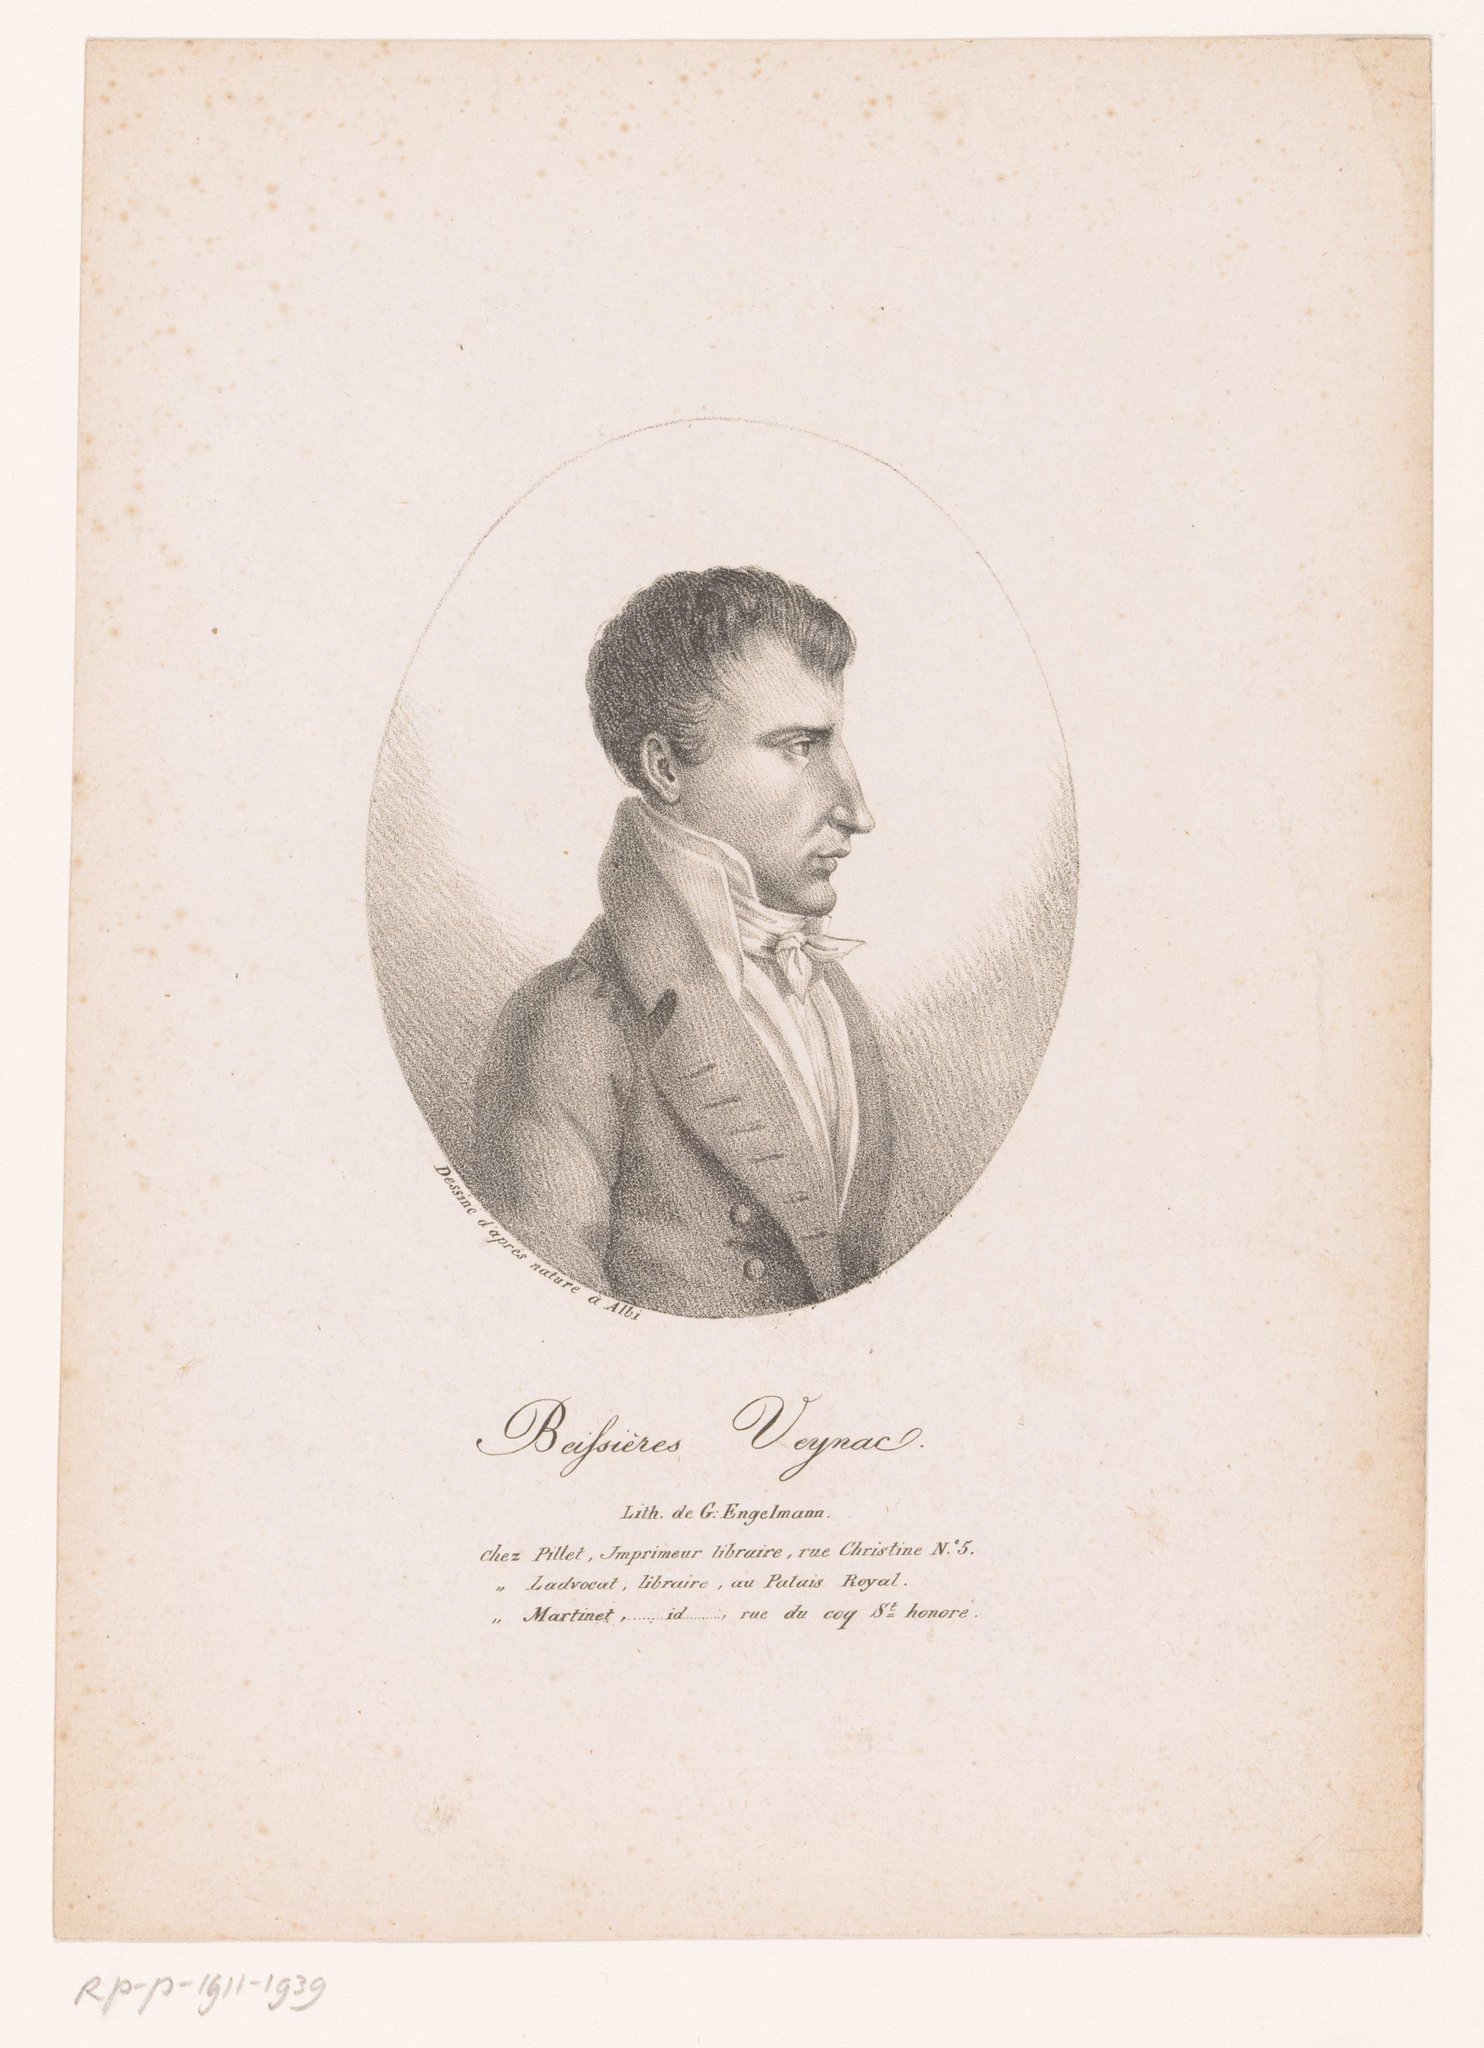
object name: print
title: Beifsières Veynac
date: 1818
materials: paper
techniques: lithograph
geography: paris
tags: historical persons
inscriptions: collector's mark: Lugt 2228a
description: Antoine Bernardin Fualdès werd op 19 maart 1817 vermoord te Rodez. Deze moord leidde in 1818 tot een rechtszaak die de geschiedenis in zou gaan als een van de beroemdste justitiële affaires van de negentiende eeuw (de 'Affaire Fualdès').